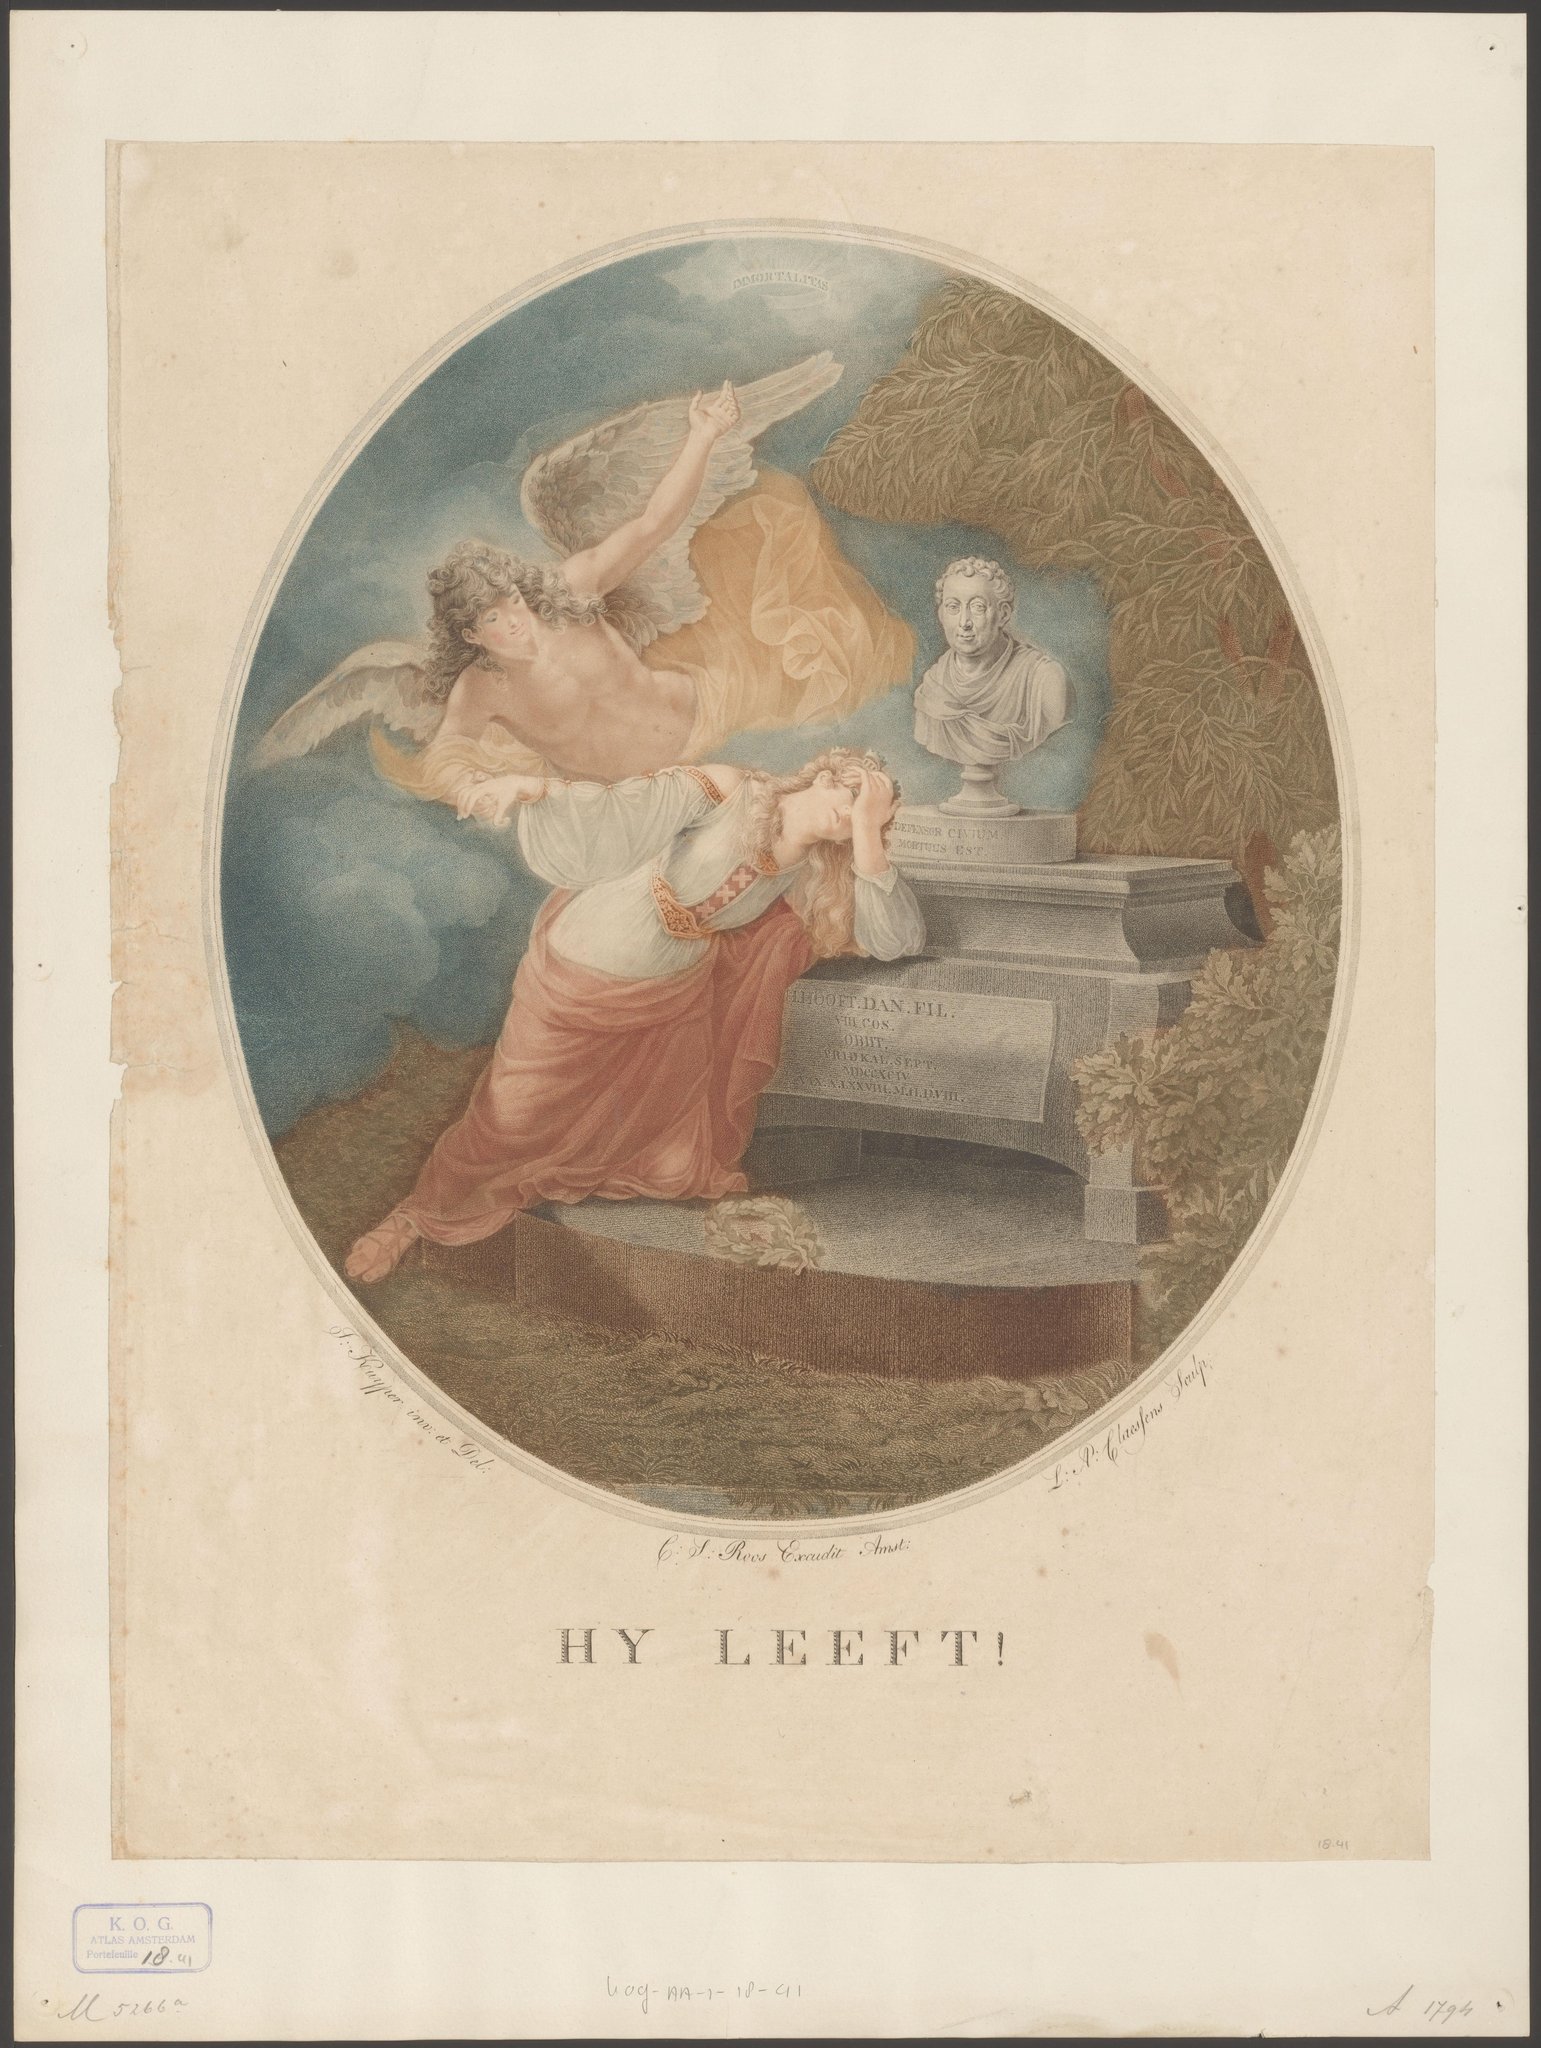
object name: print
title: Allegorie op het overlijden van Hendrik Danielsz. Hooft, 1794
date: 1794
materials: paper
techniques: color etching, stippling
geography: amsterdam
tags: amsterdam, mayor, hendrik danielsz. hooft, personification of a city, town-patron(ess), grave, tomb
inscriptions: collector's mark: ‘18.41’ Lugt 1641b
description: Onderwerpsrubriek binnen de Atlas Amsterdam: Herinneringen aan regeringsleden en hunne huisgezinnen [voor 1800].